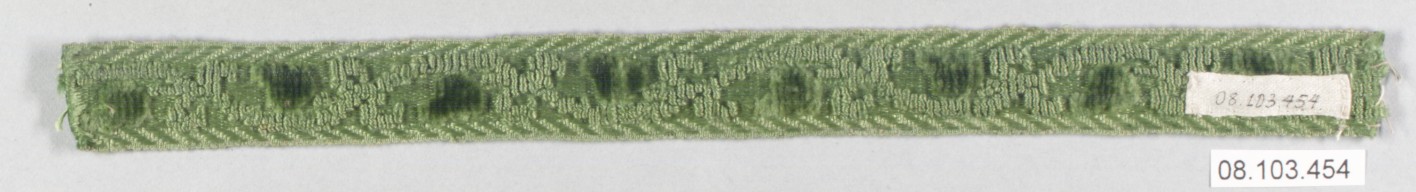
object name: galloon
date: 1801-1833